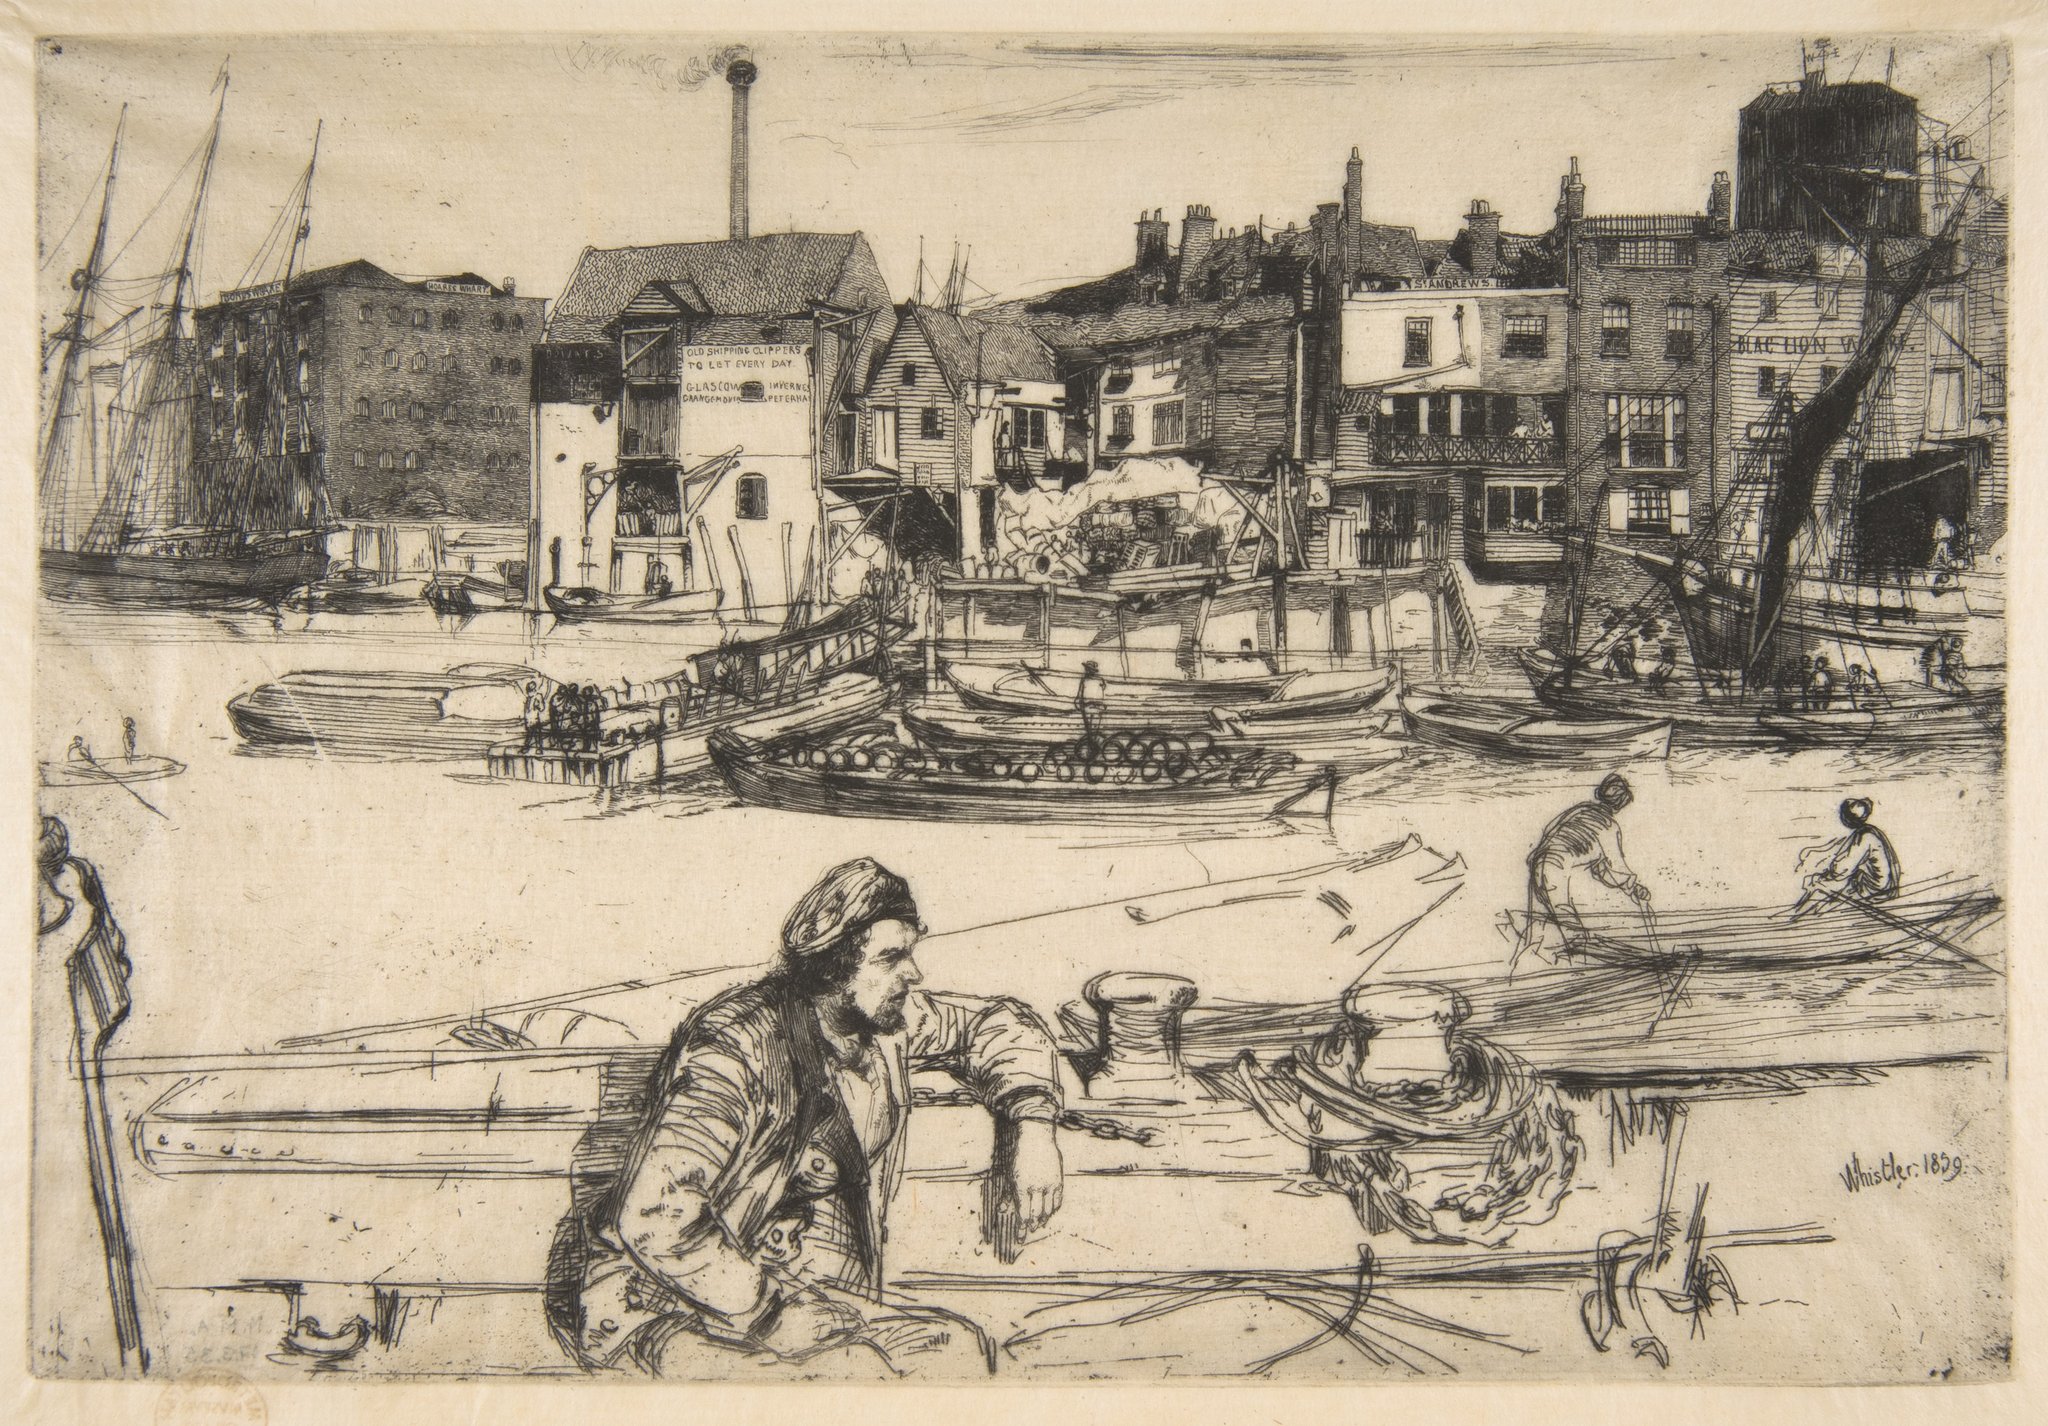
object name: print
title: Black Lion Wharf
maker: james mcneill whistler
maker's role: artist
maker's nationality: american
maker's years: 1834-1903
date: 1859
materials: ink, paper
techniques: etching, printing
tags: docks,men,boats